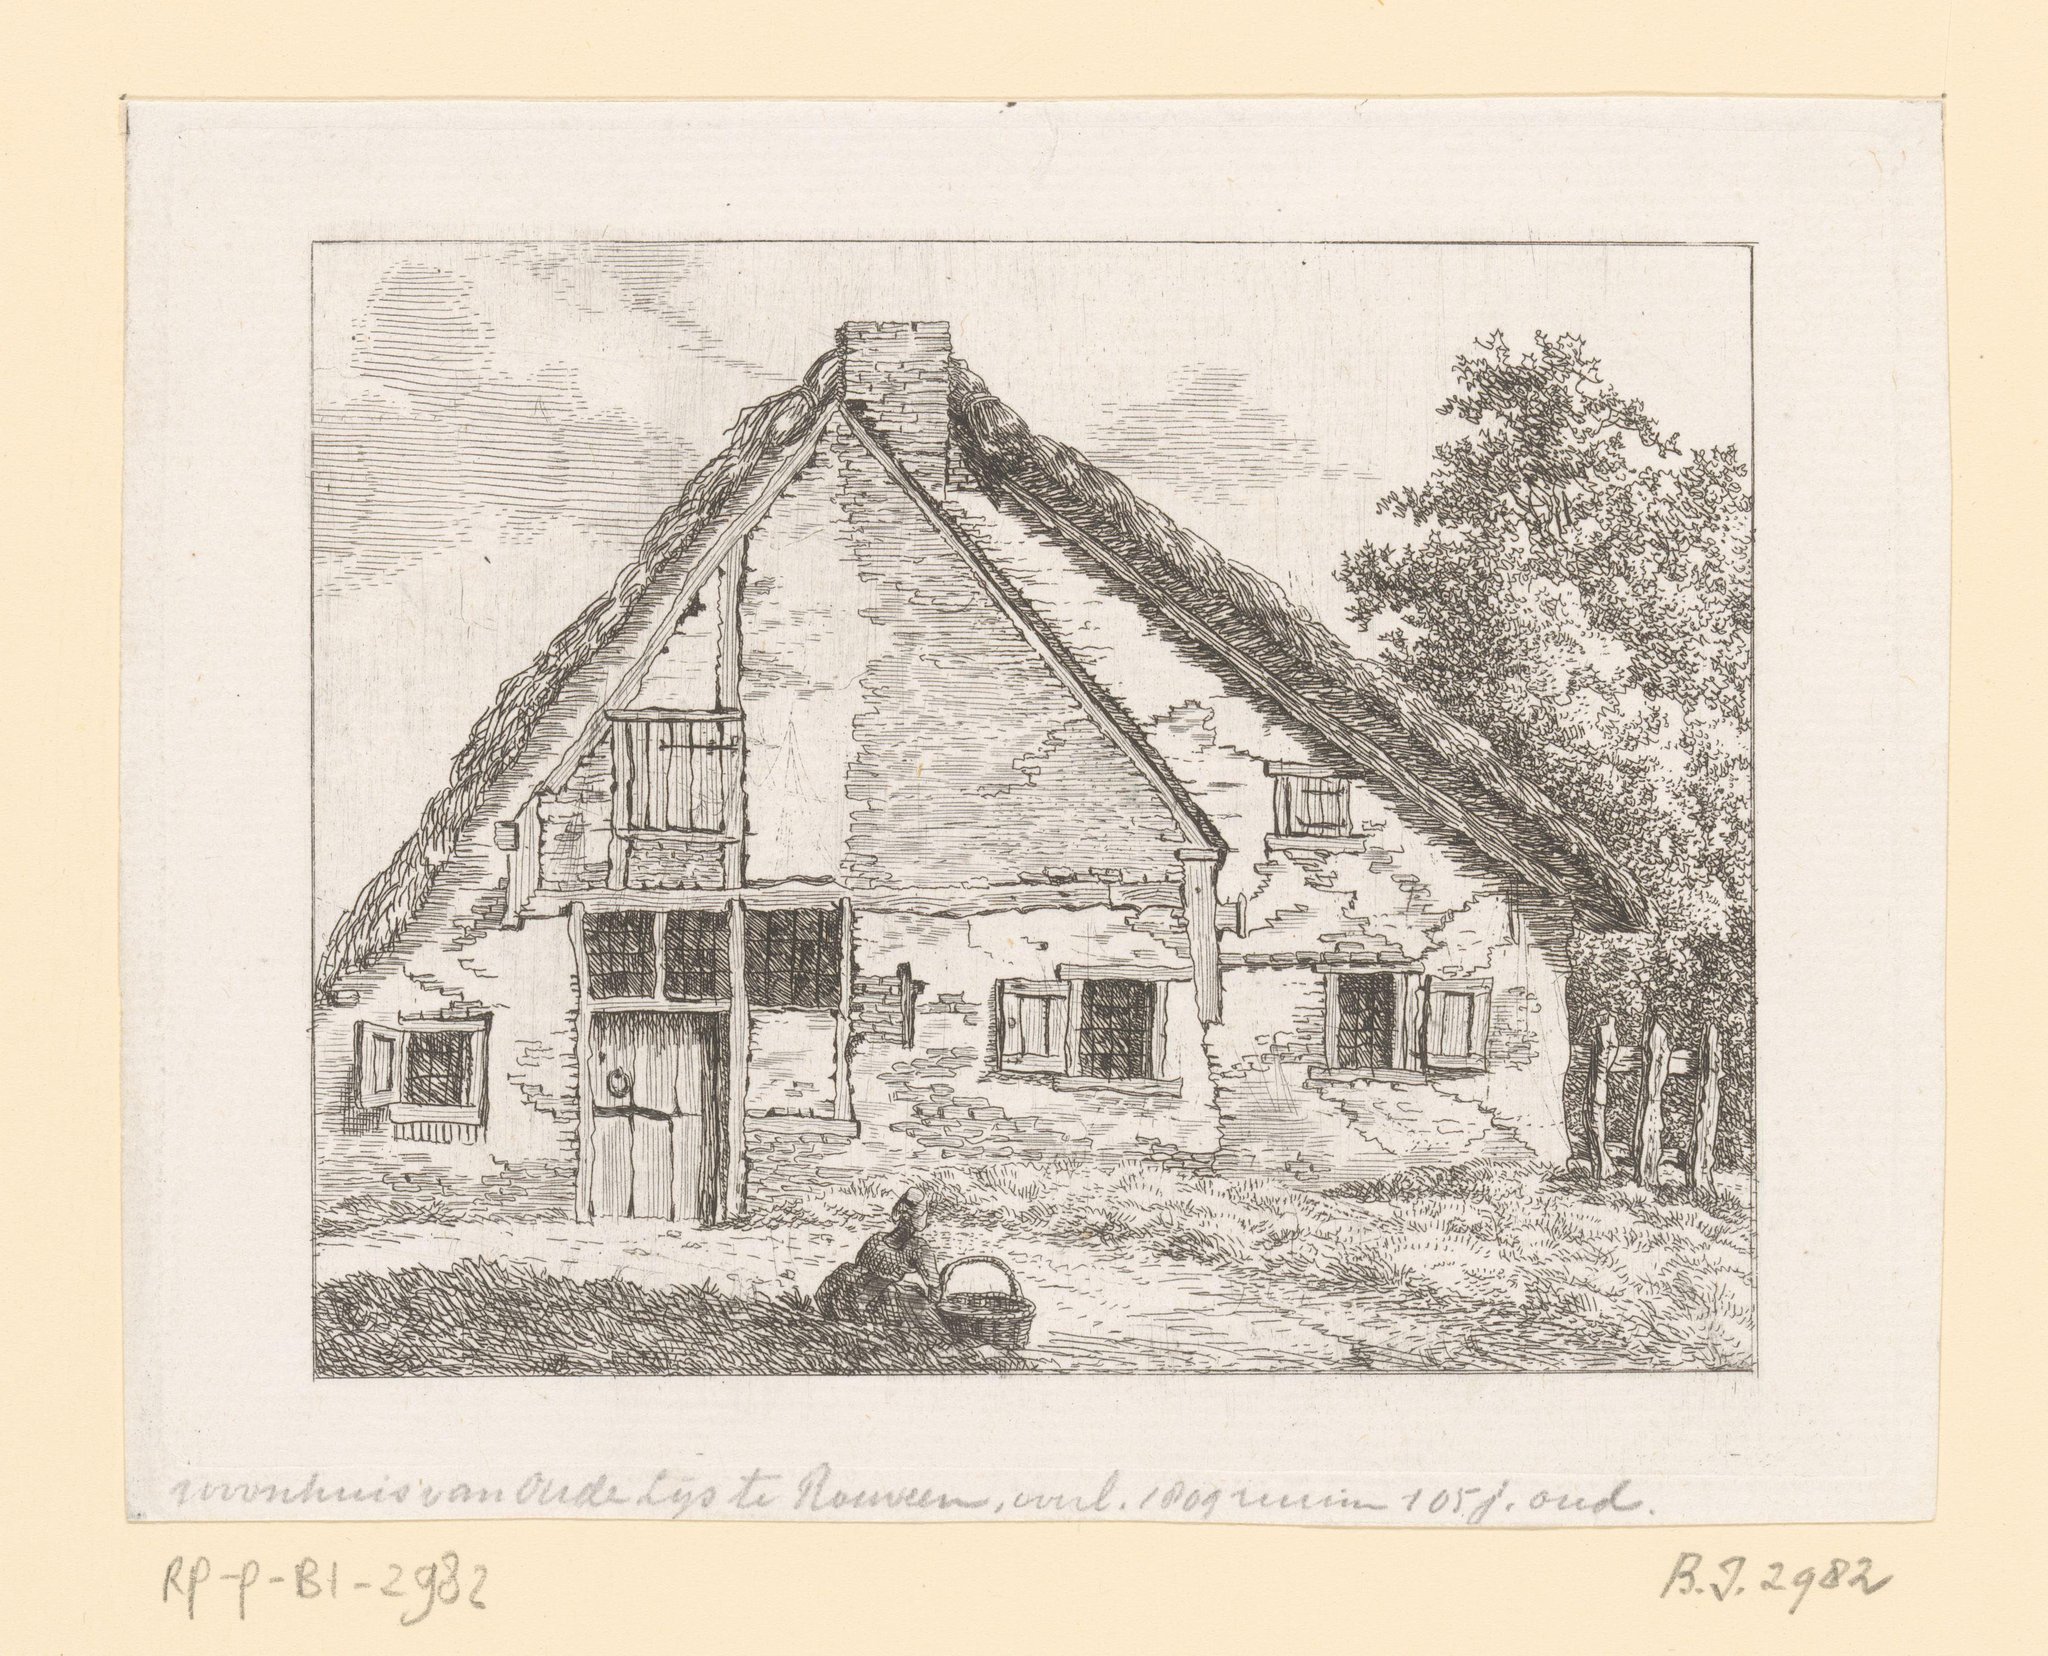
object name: print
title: Vrouw met mand zittend voor een boerderij te Rouveen bij Staphorst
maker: anthonie van den bos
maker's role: draughtsman, print maker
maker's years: 1763-1838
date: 1809-1838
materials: paper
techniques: etching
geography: netherlands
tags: sitting figure, farm (building)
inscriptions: collector's mark: Lugt 2228